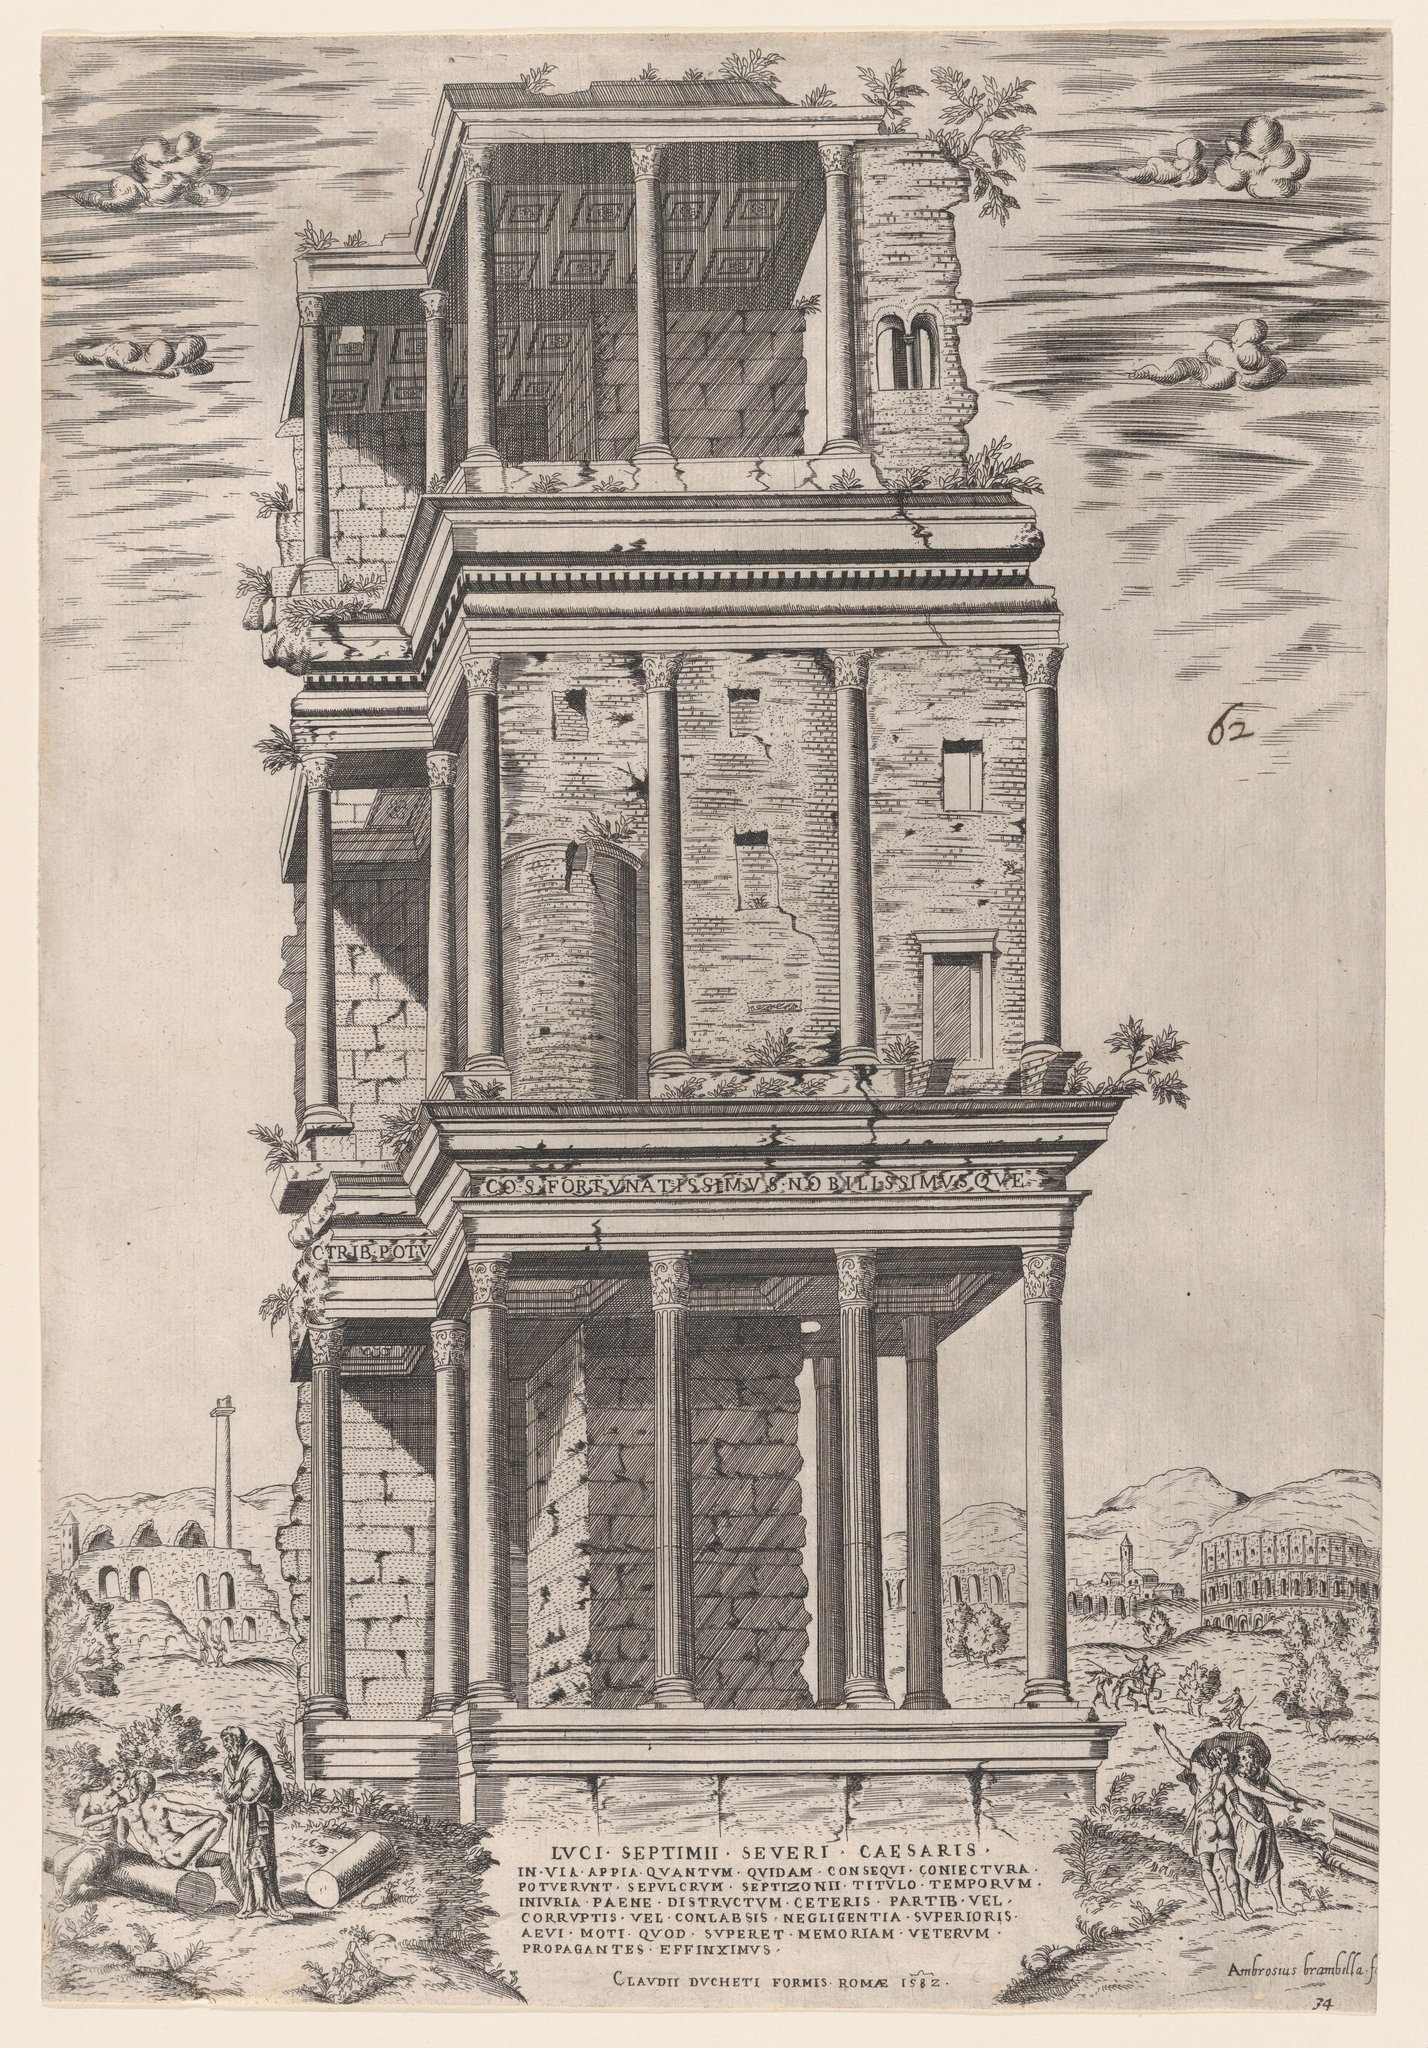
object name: print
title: The Septizodium, from "Speculum Romanae Magnificentiae"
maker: giovanni ambrogio brambilla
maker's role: artist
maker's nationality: italian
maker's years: 1575-1599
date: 1582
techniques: engraving, etching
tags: architecture,columns,rome